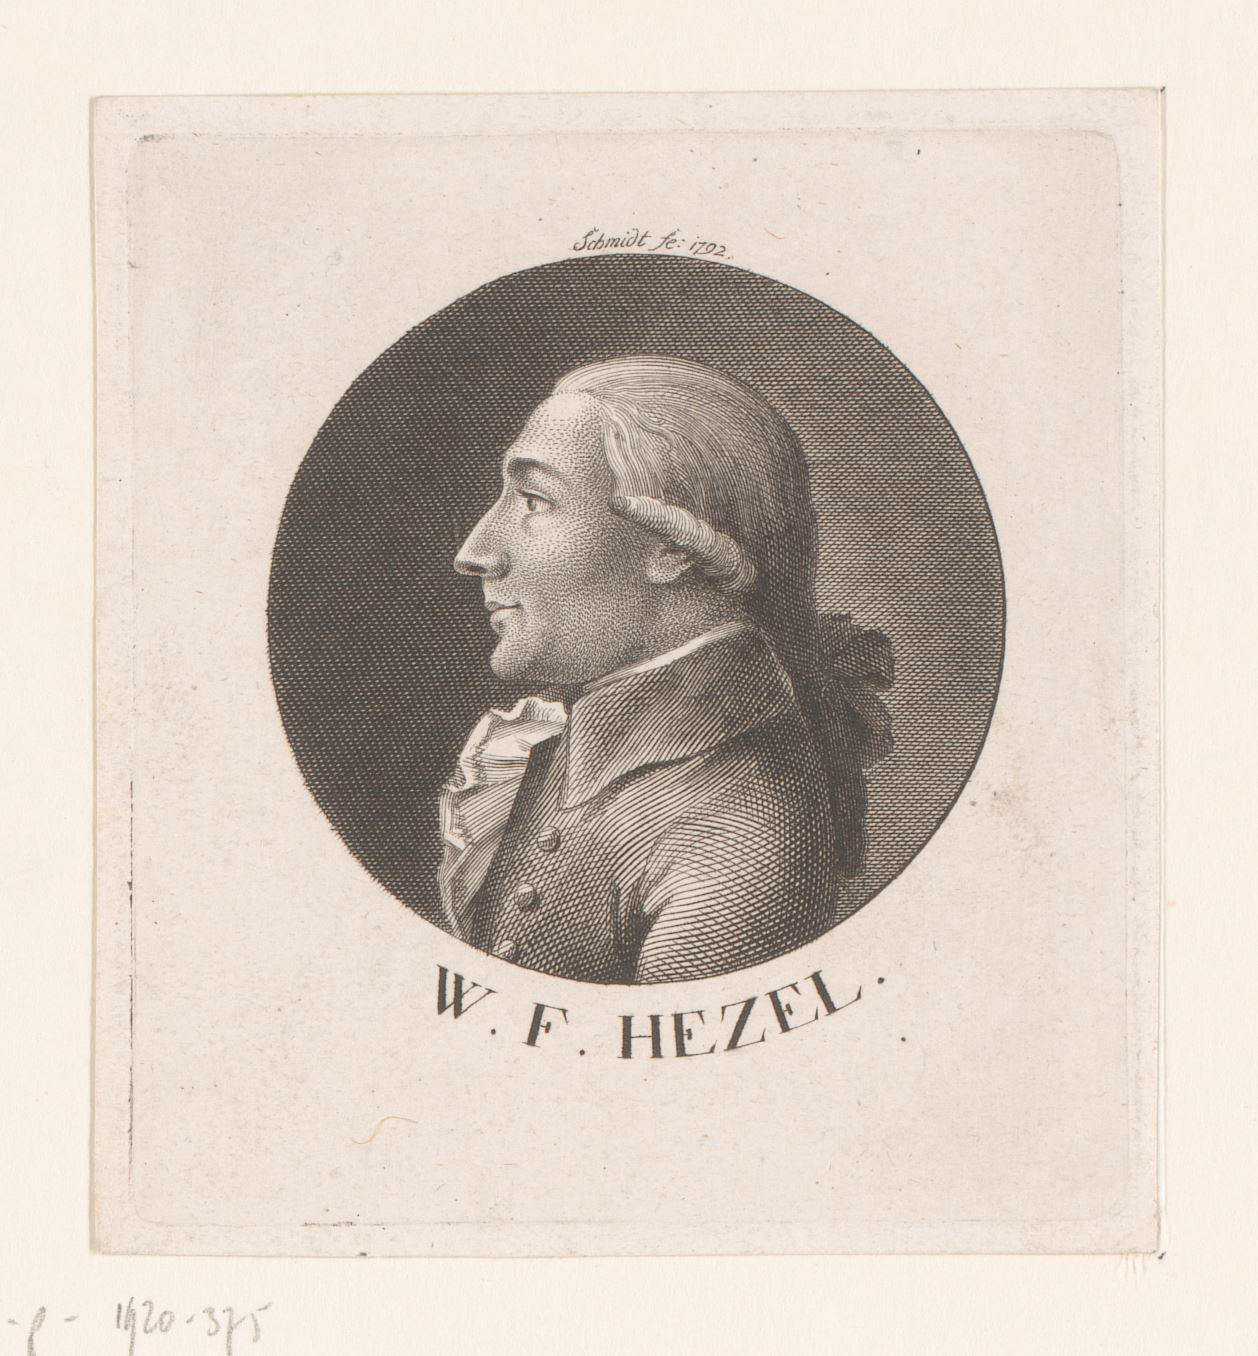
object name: print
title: Portret van Wilhelm Friedrich Hezel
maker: georg christoph schmidt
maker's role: print maker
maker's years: 1740-1811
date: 1792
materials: paper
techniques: engraving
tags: historical persons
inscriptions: collector's mark: Lugt 2228